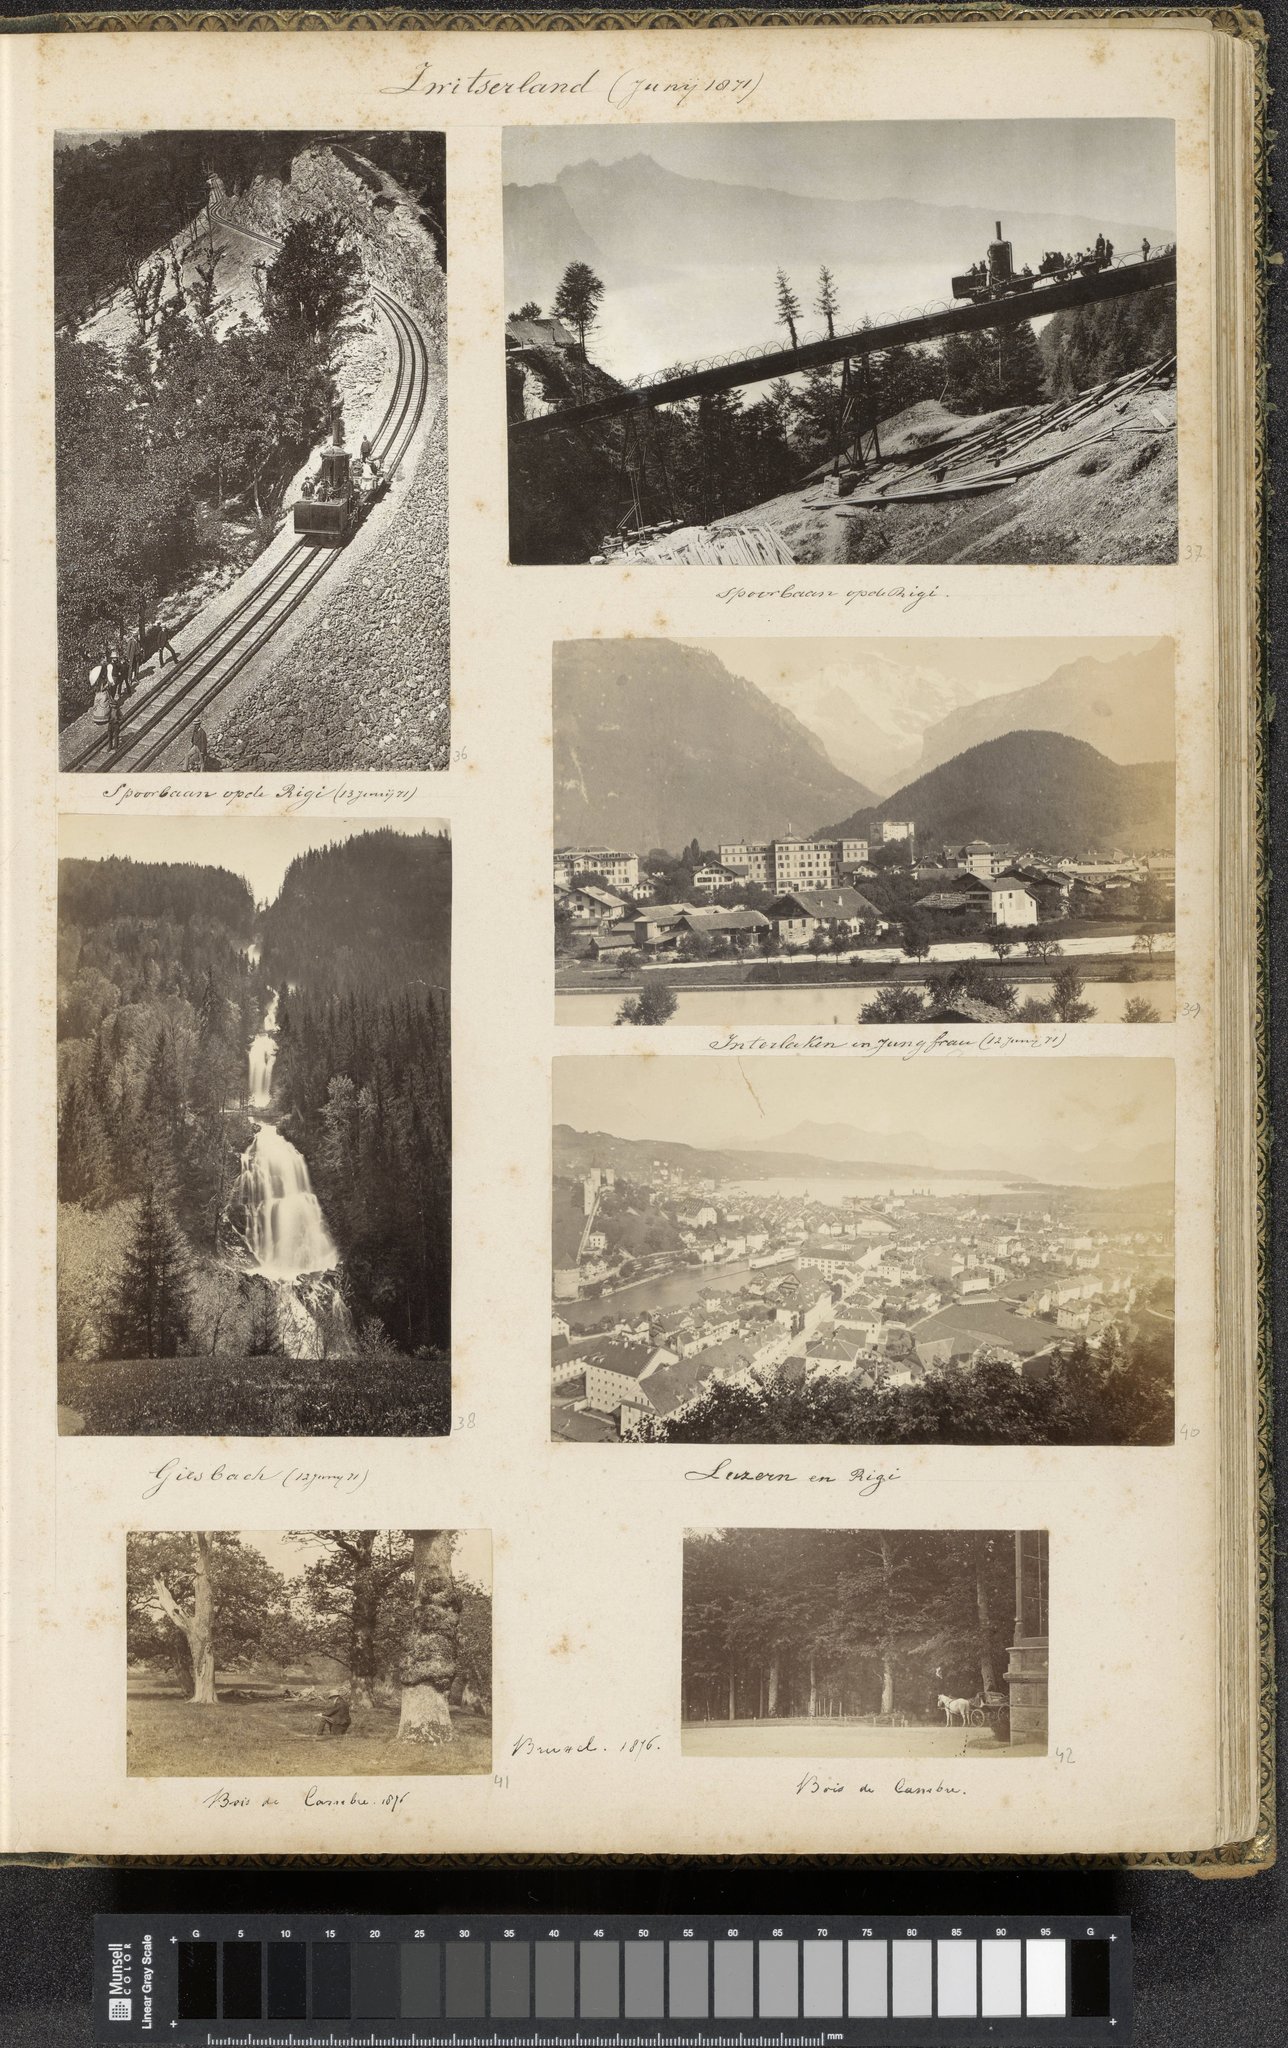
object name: photograph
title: Man zit te tekenen in het Ter Kamerenbos (Bois de la Cambre) te Brussel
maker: Anonymous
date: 1876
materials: paper, photographic support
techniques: albumen print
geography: brussels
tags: drawing, forest, wood, public gardens, park, brussels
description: Onderdeel van Fotoalbum van Robert Daniel Crommelin (1841-1907).